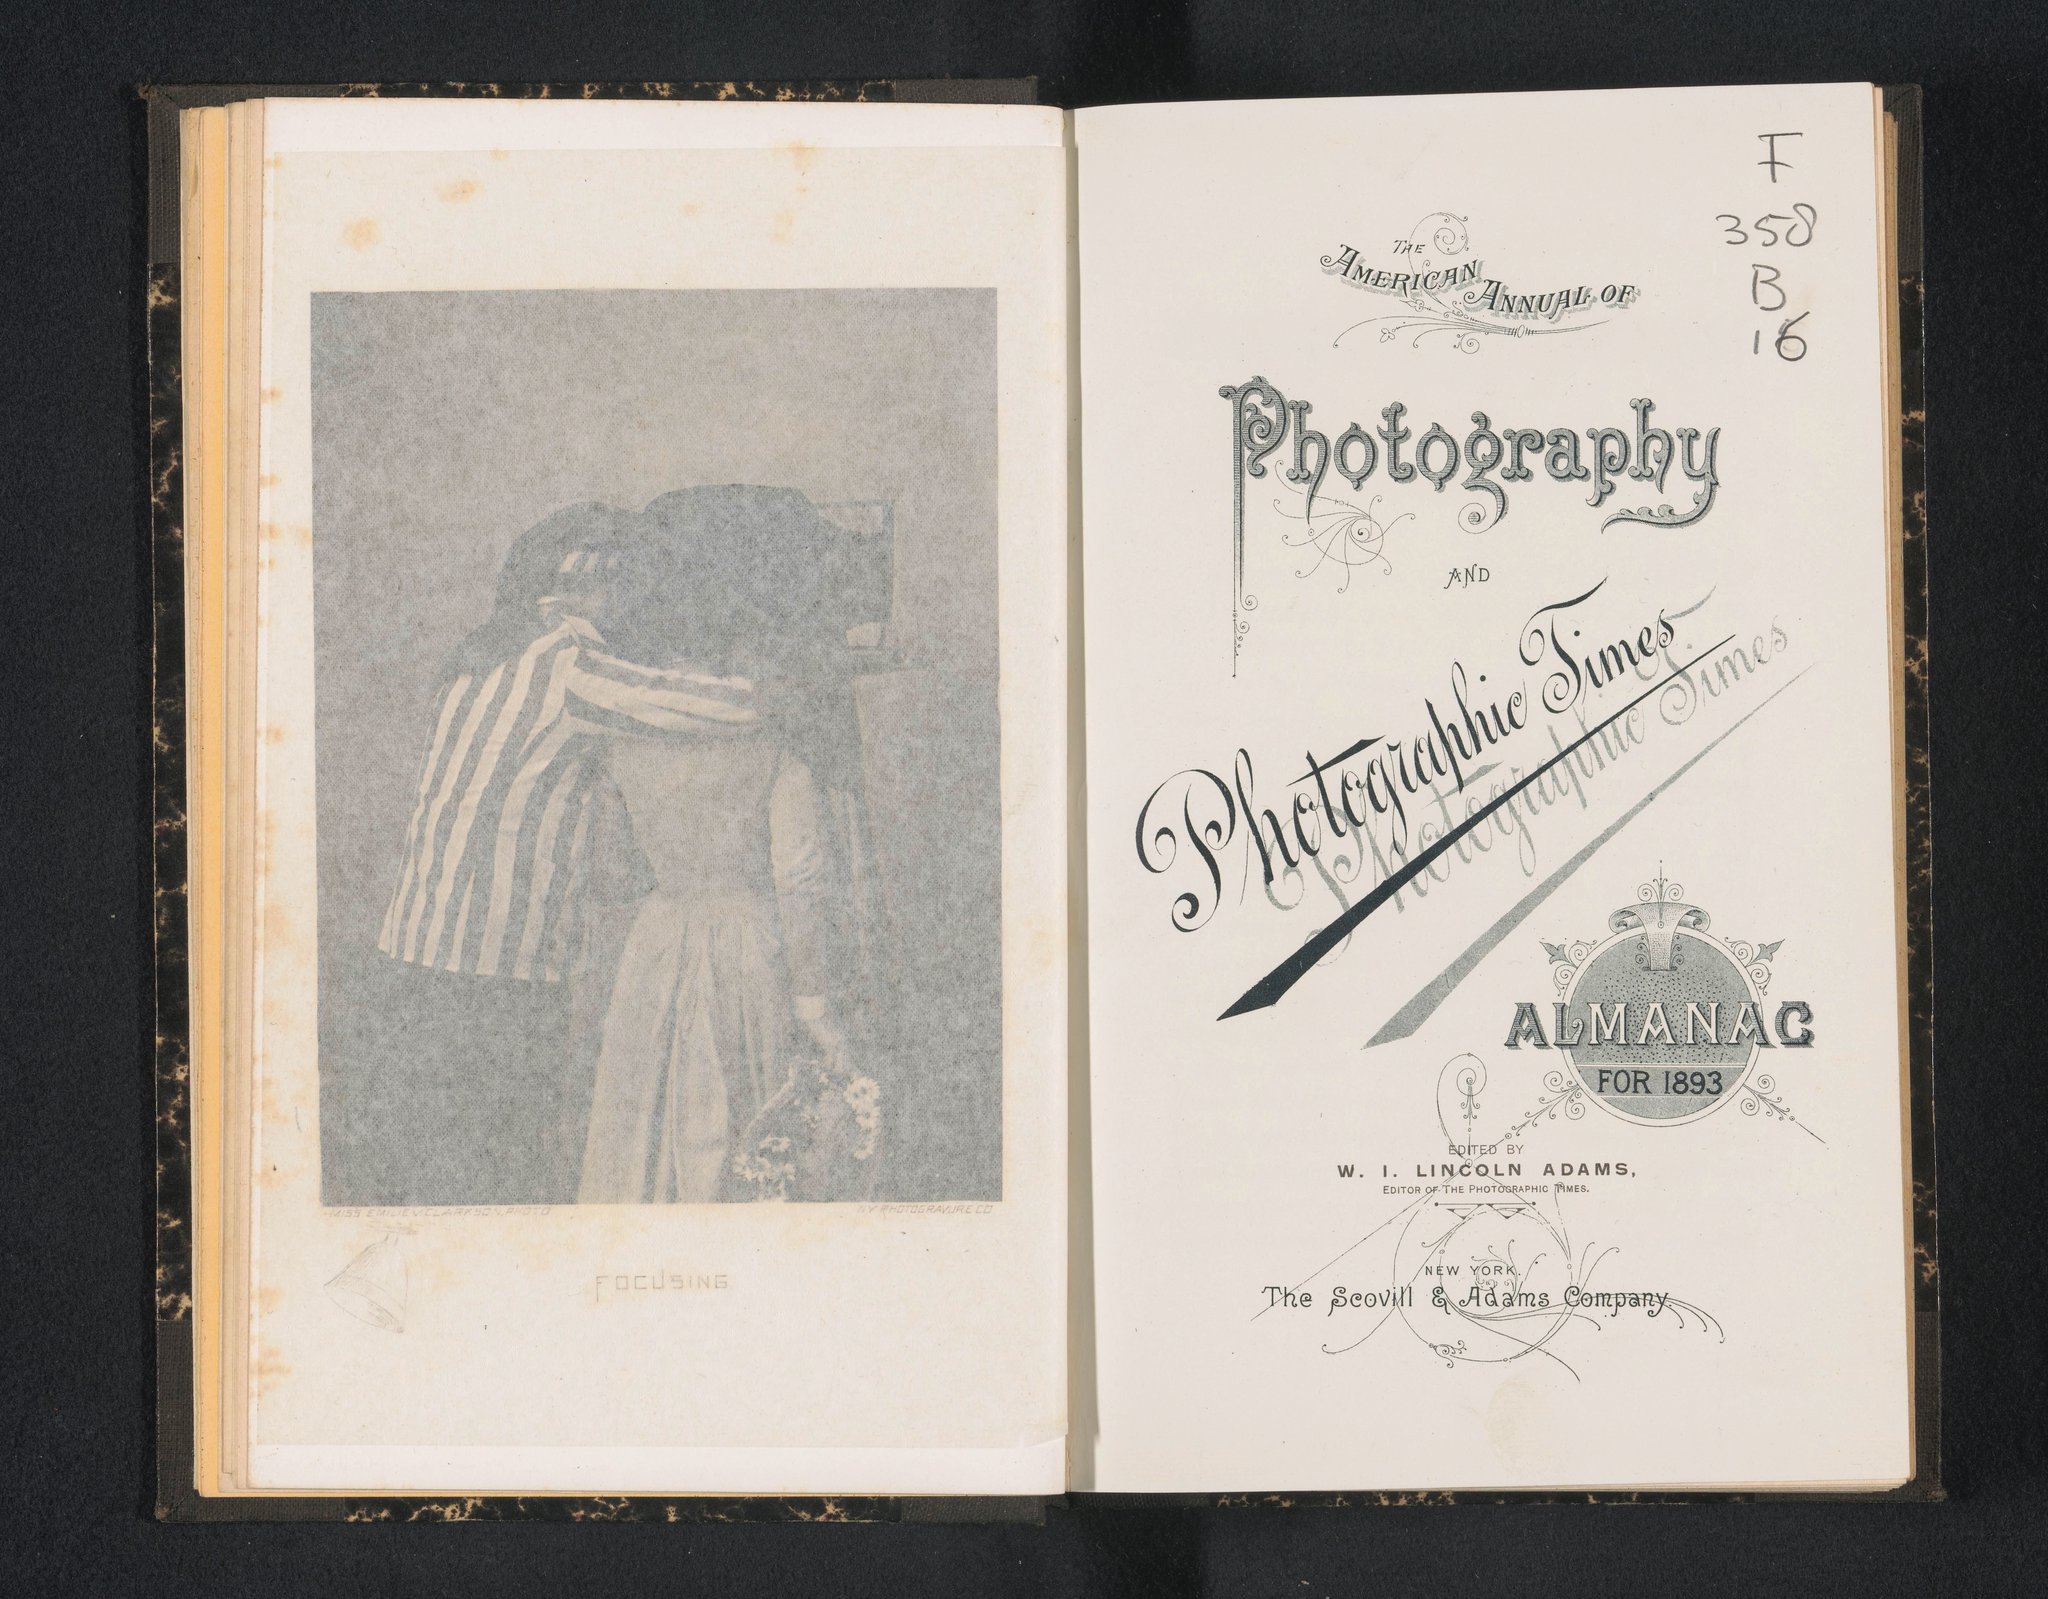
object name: book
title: The American annual of photography and photographic times almanac for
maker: washington irving lincoln adams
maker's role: politician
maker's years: 1865-1946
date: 1887-1907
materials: linen, paper, photographic support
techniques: photograph, printing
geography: new york city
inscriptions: date: ‘May 1998’, annotation: ‘95580/ 300,-/ [...] cataloge photographicus’